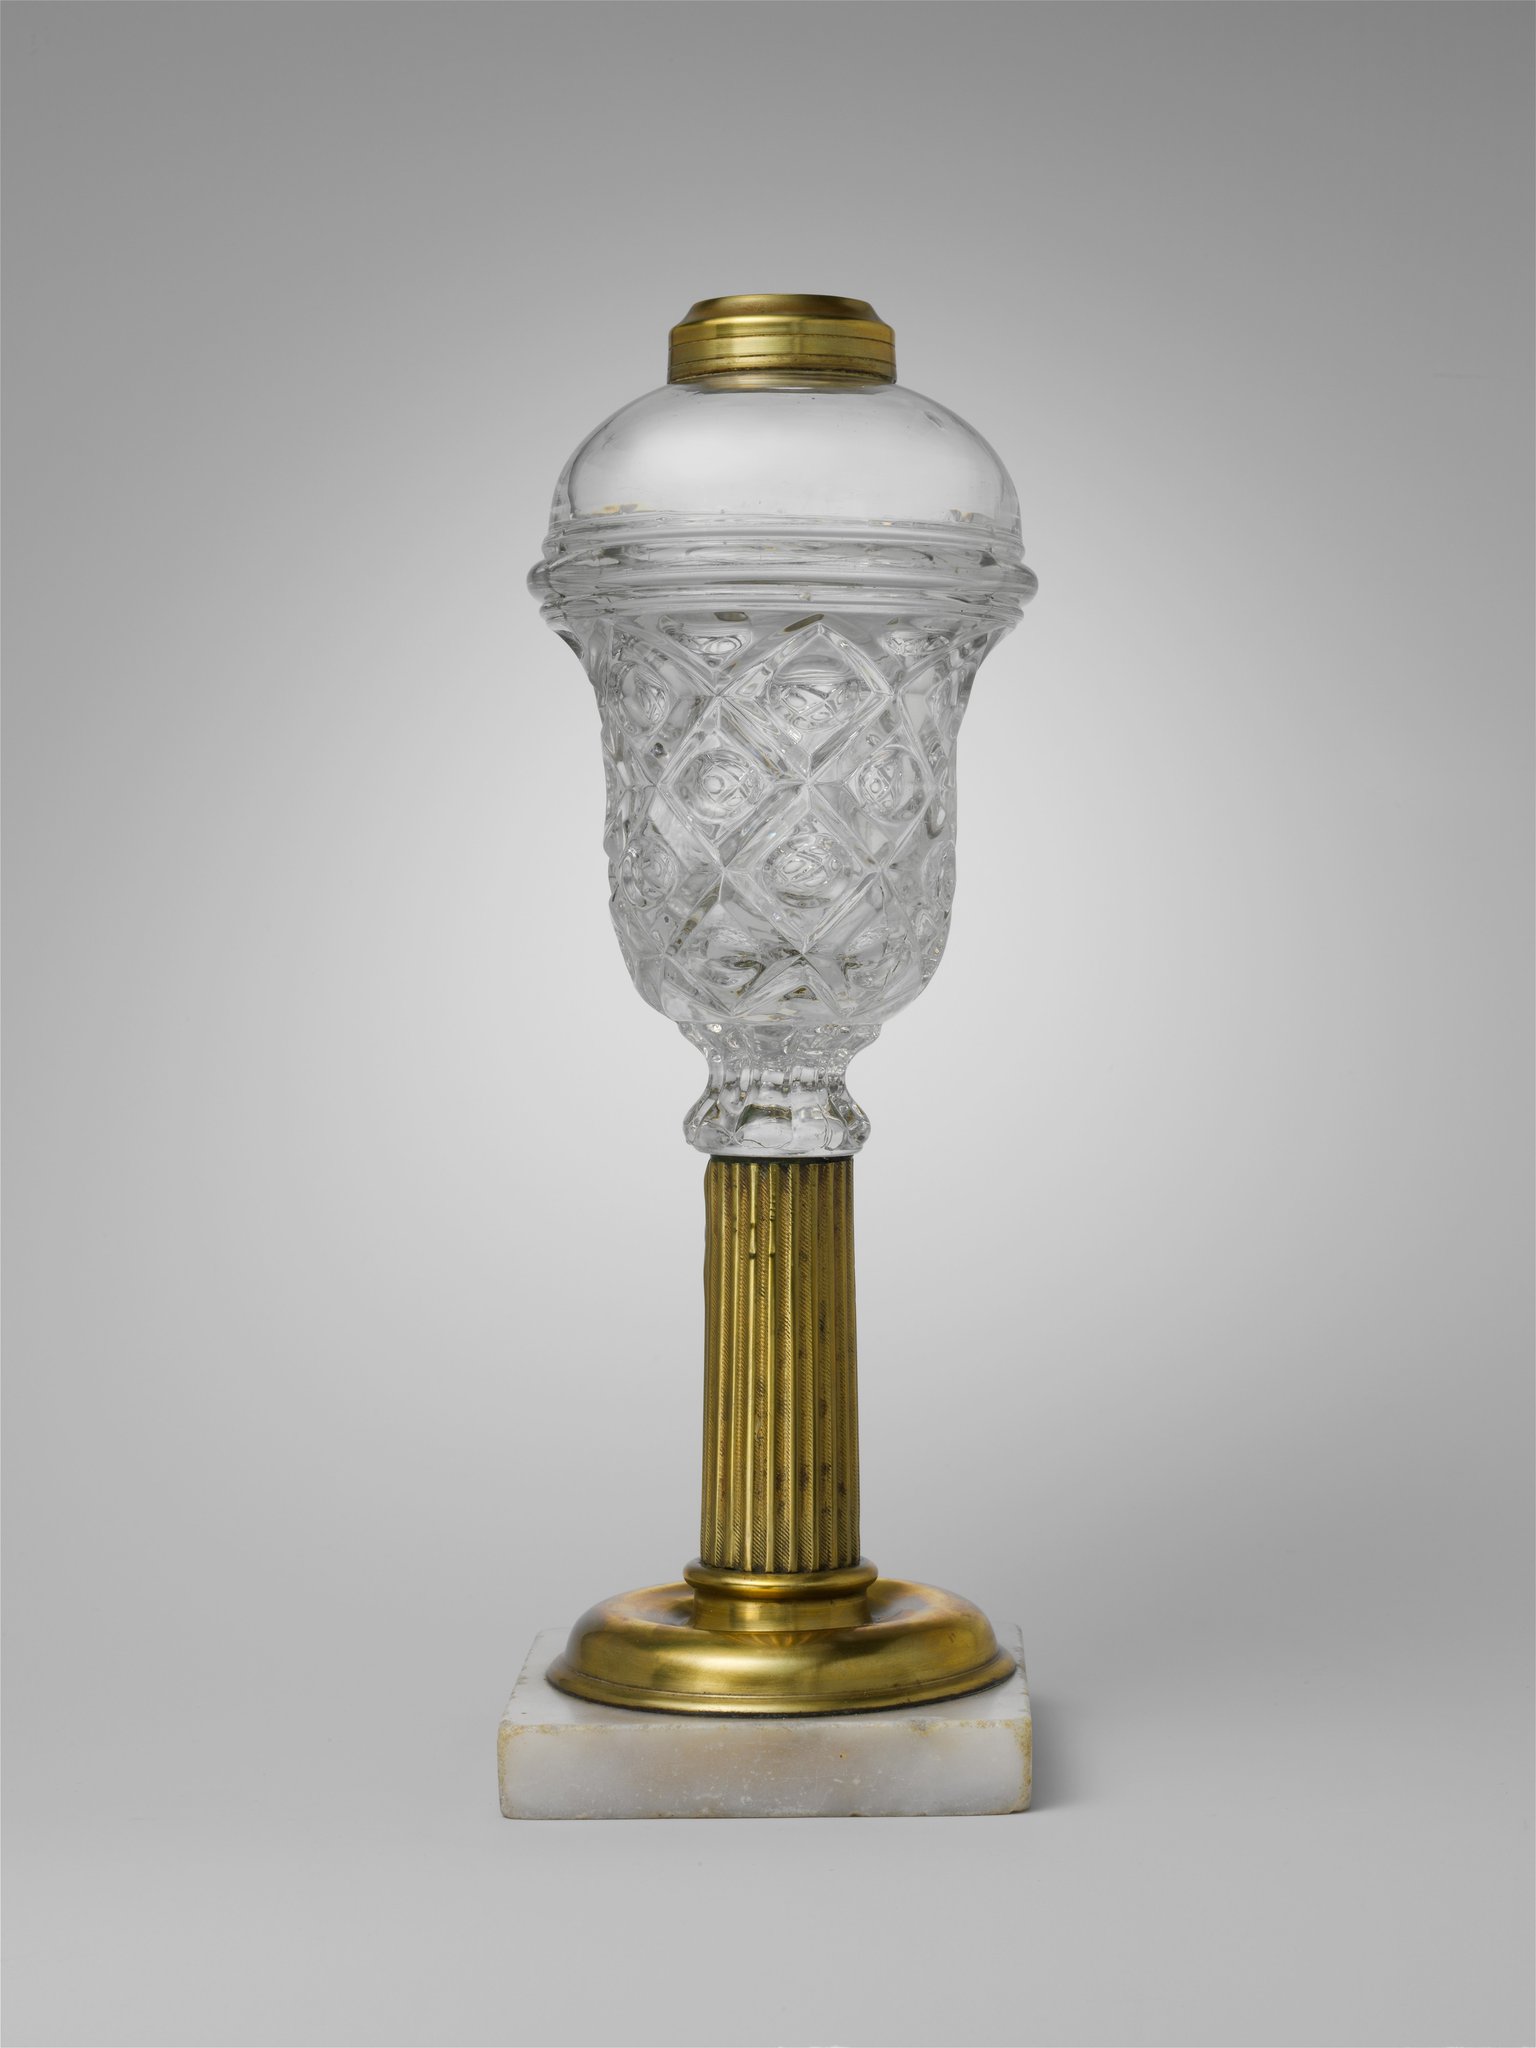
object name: candlestick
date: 1850-1860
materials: glass